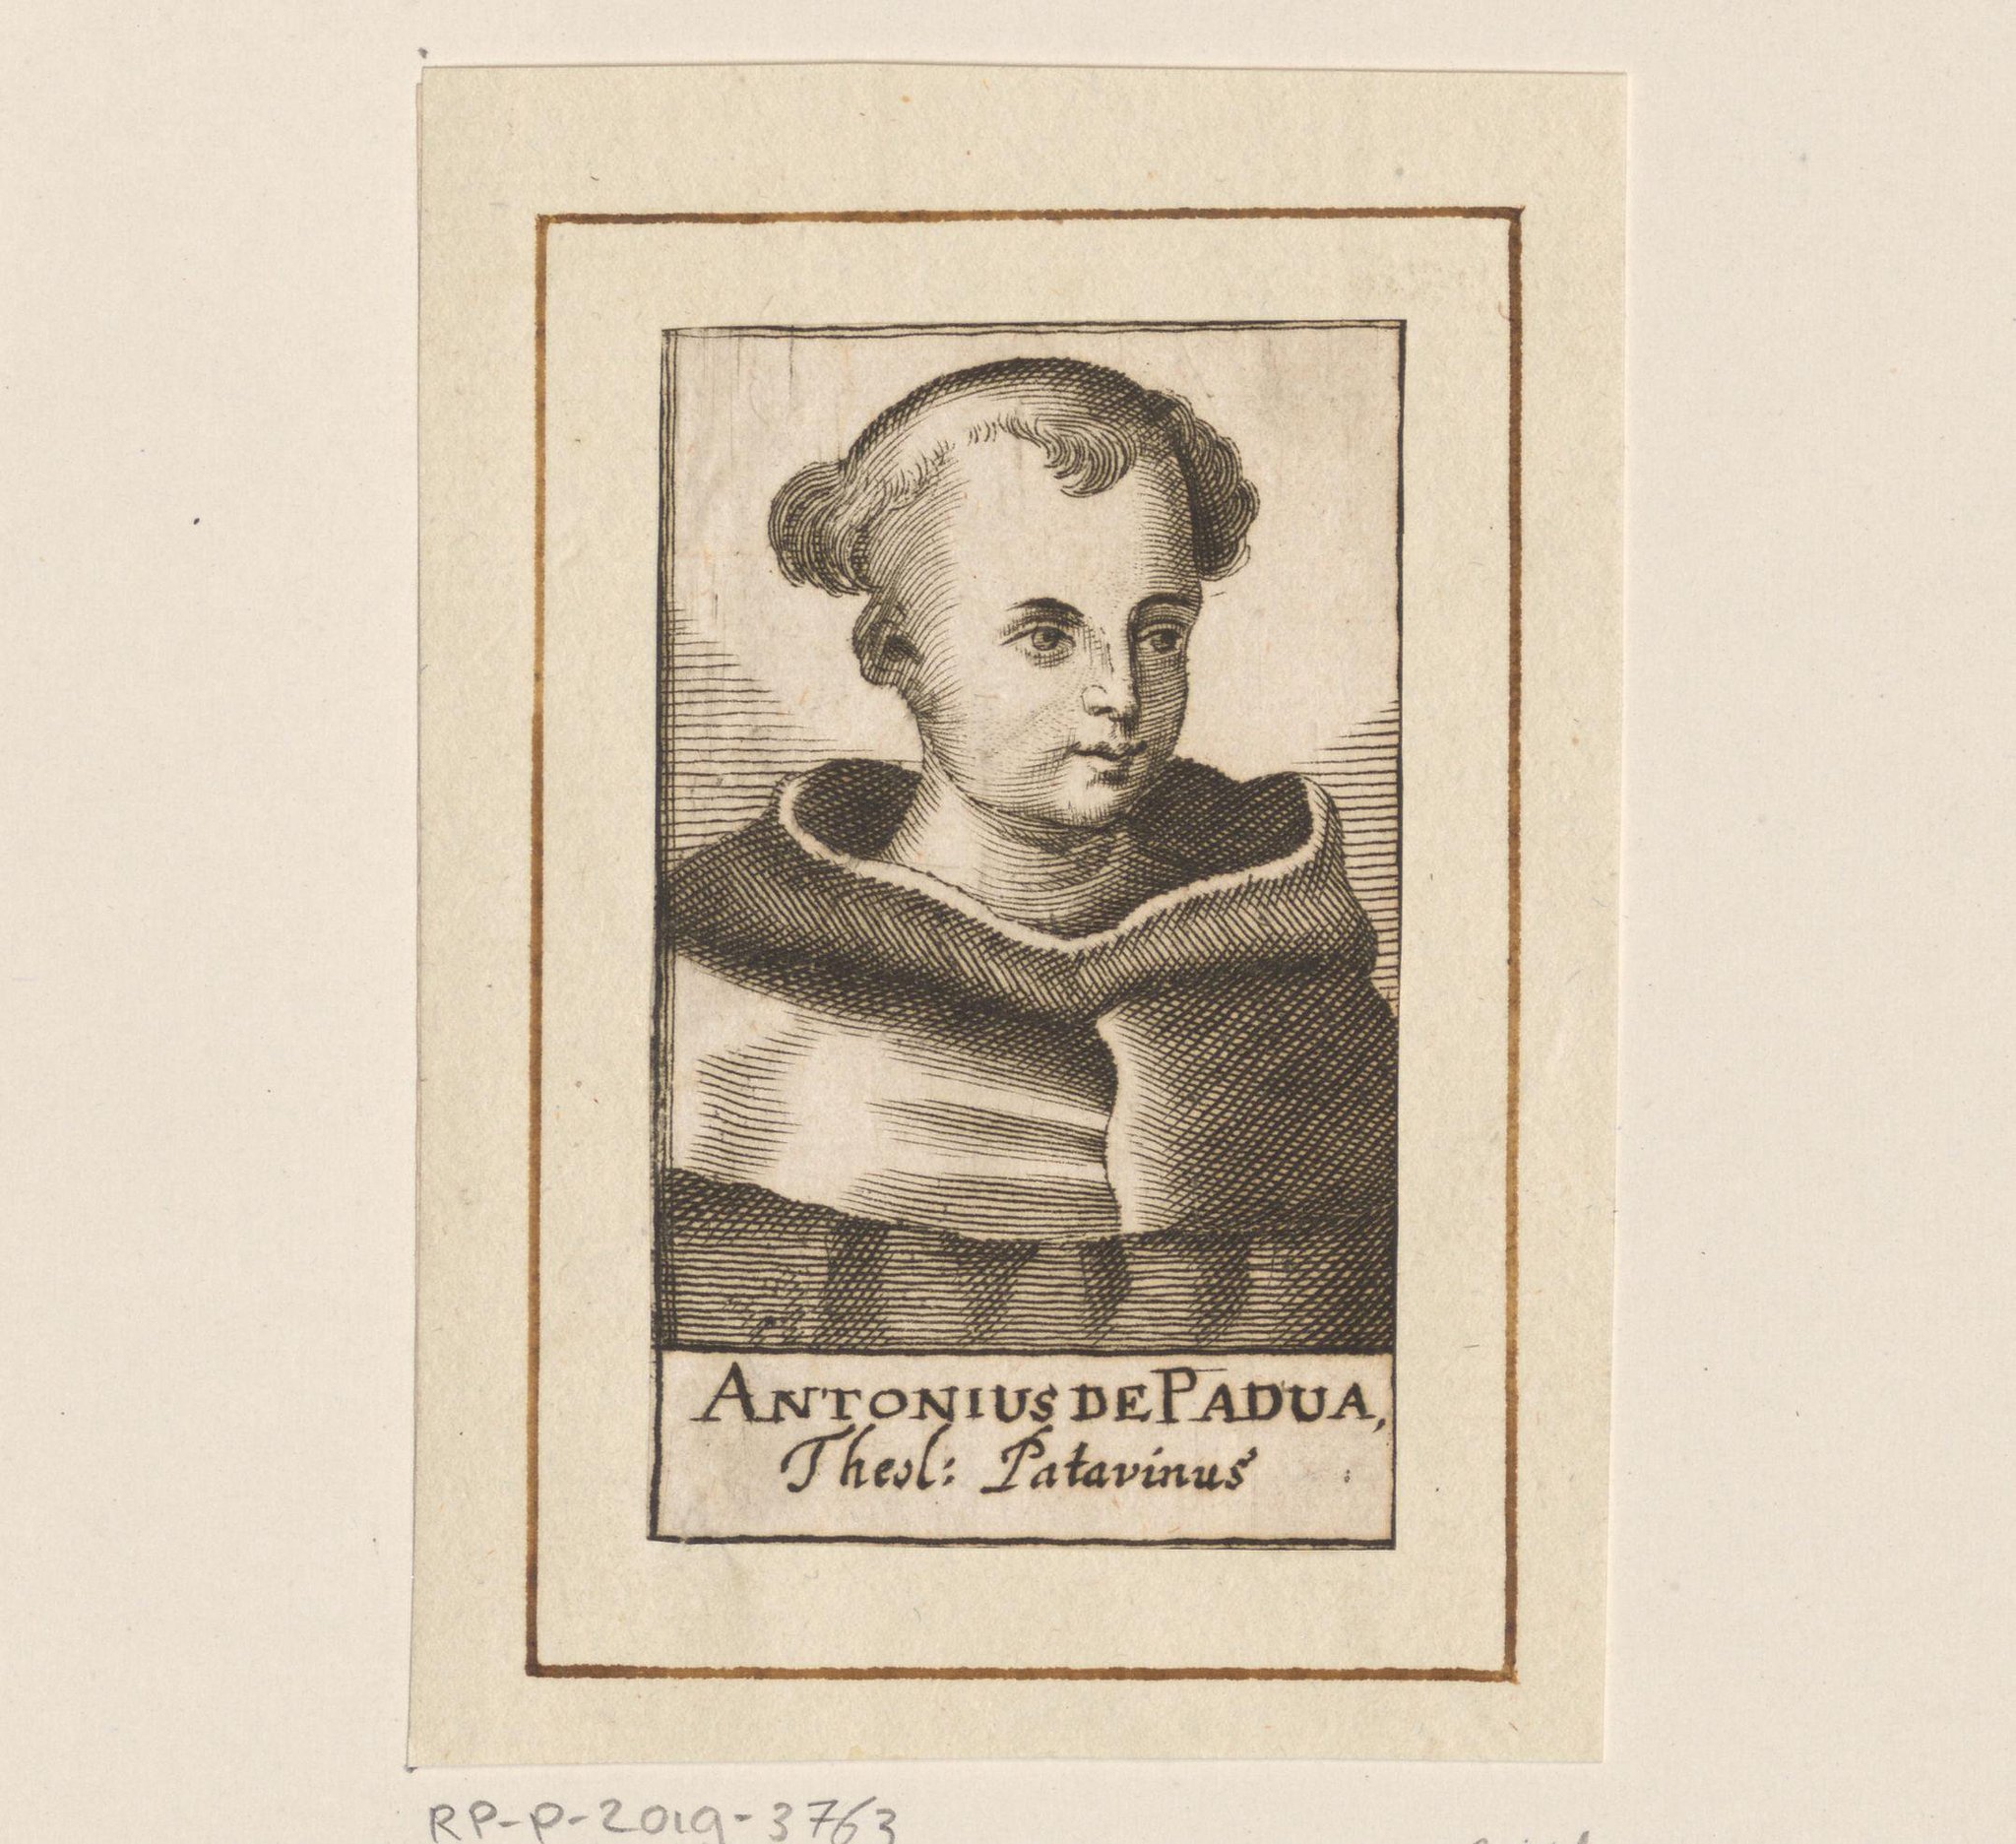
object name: print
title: Portret van Antonius van Padua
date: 1688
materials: paper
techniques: engraving, etching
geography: nuremberg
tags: clergyman, theologian, historical persons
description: Prent uit: Freher, Paul. Theatrum virorum eruditione clarorum. Neurenberg: Johann Hoffmann, 1688.